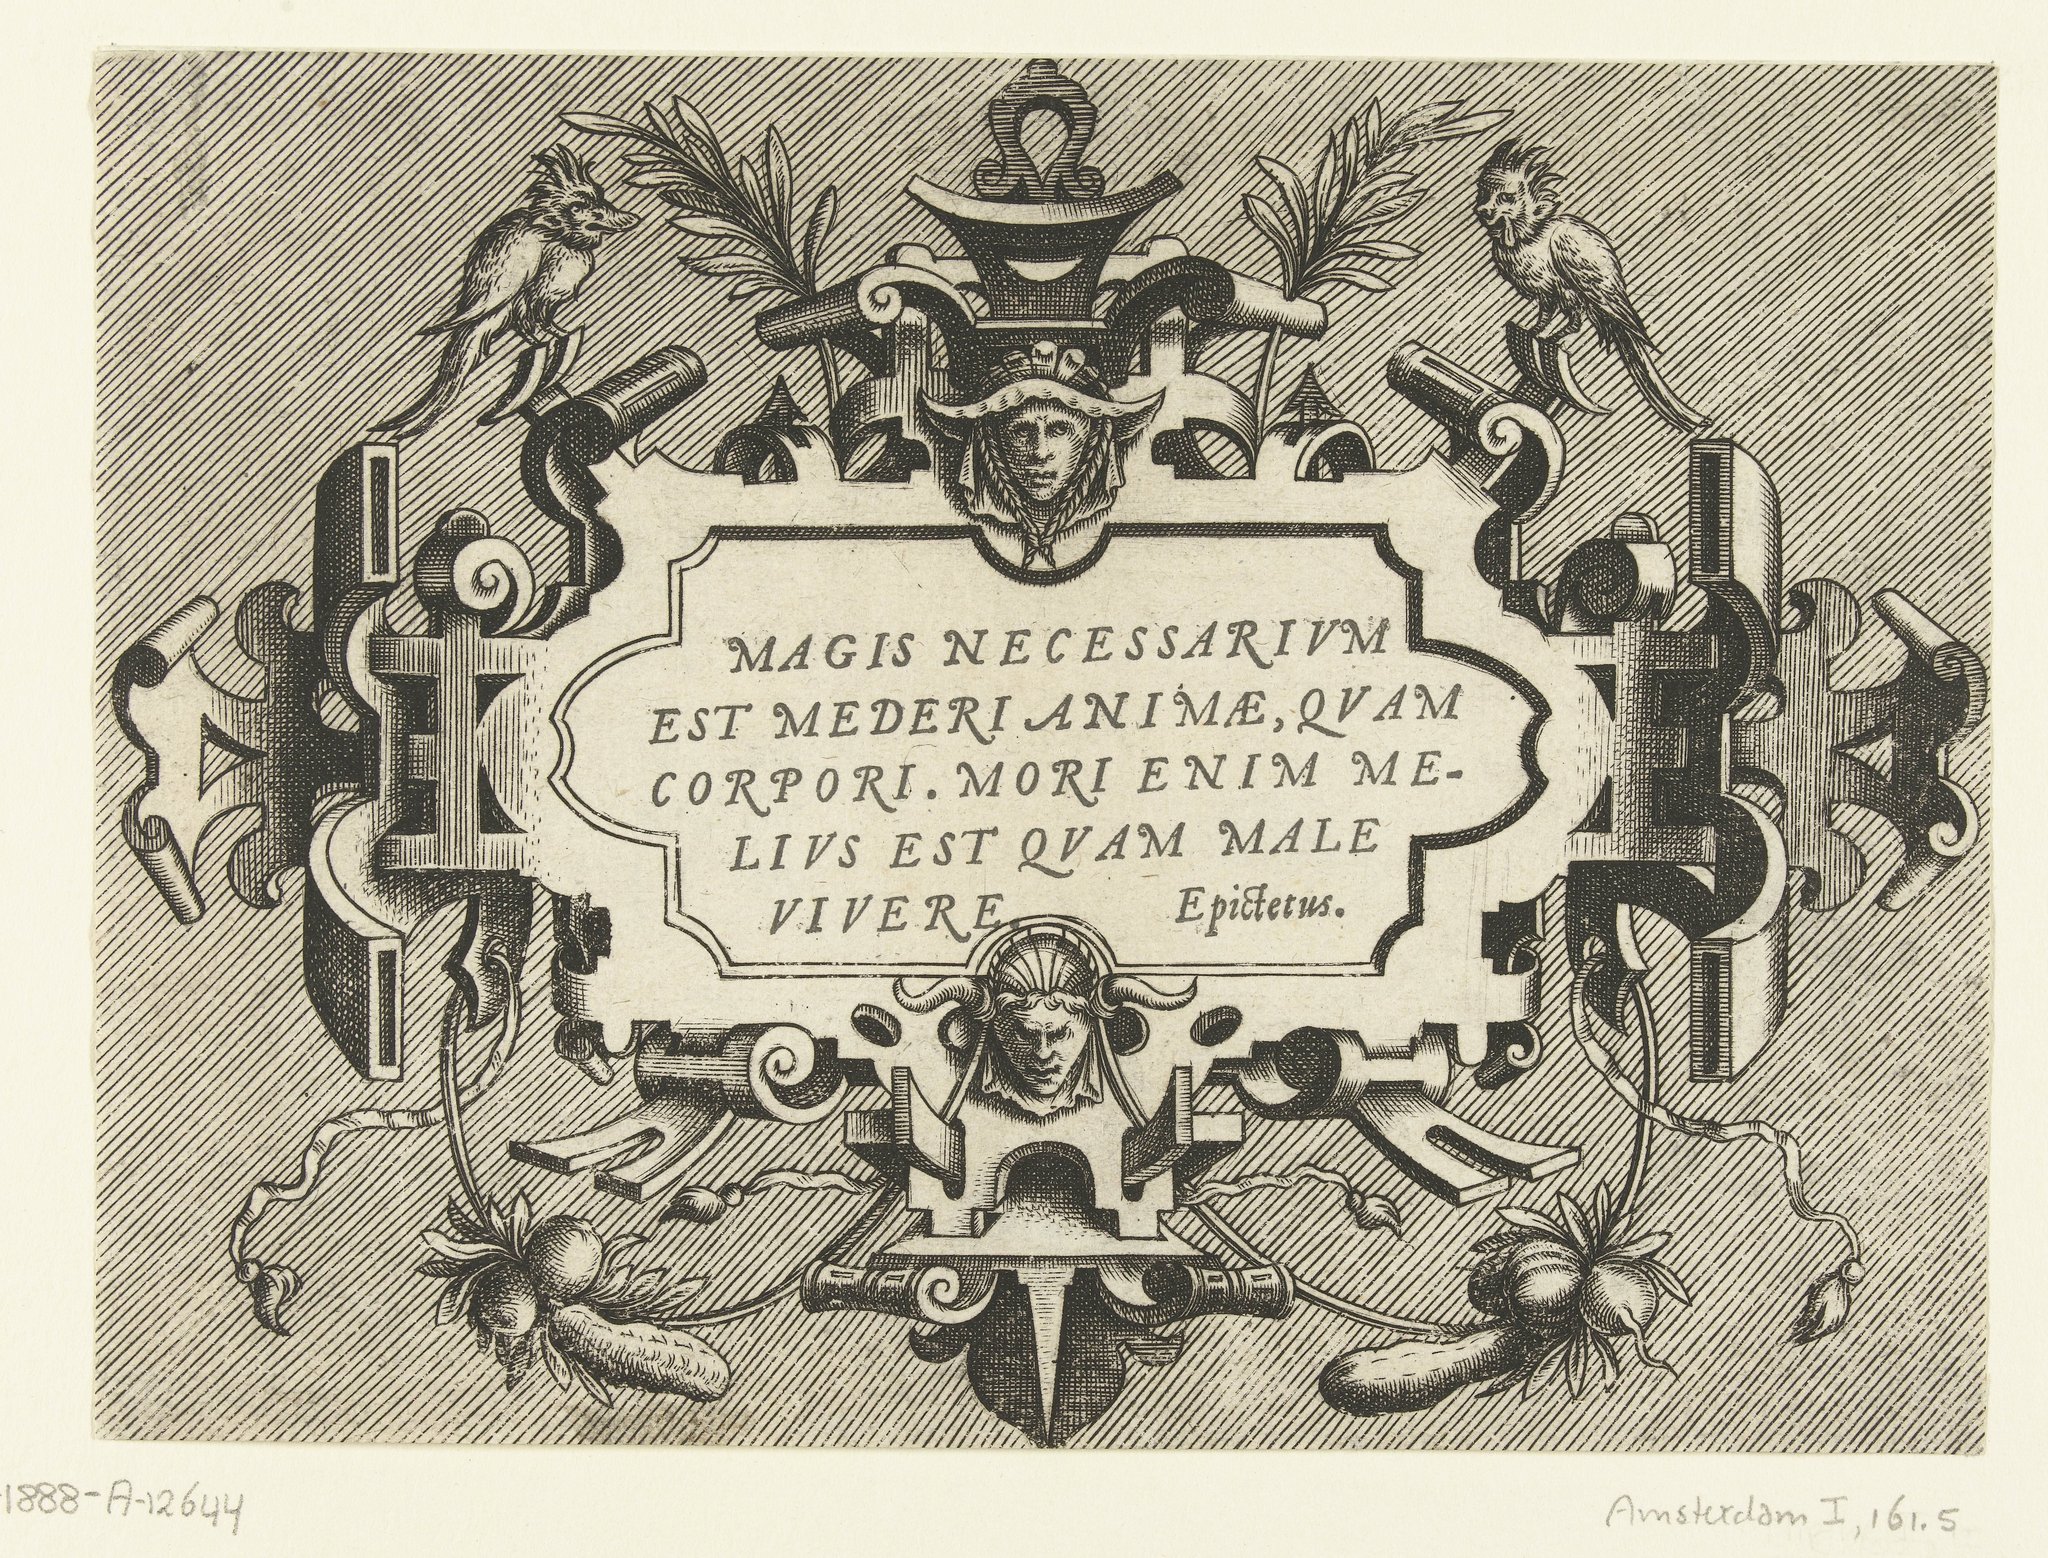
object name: ornament print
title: Cartouche met een citaat van Epictetus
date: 1555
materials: paper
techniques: etching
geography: netherlands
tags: ornament derived from animal forms, ornament ~ cartouche, ornament ~ festoon, garland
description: Citaat: MAGIS NECESSARIVM EST MEDERI ANIMAE, QVAM CORPORI . MORI ENIM MELIVS EST QVAM MALE VIVERE in carouche. Links- en rechtsboven zit een vogelachtig wezen op de cartouche. Links- en rechtsonder hangt een vruchtentros aan een lint. Gearceerde achtergrond. Uit serie van titelblad en 12 bladen met cartouches met citaten van klassieke schrijvers in een omlijsting van rolwerk met grotesken, mascarons en guirlandes.